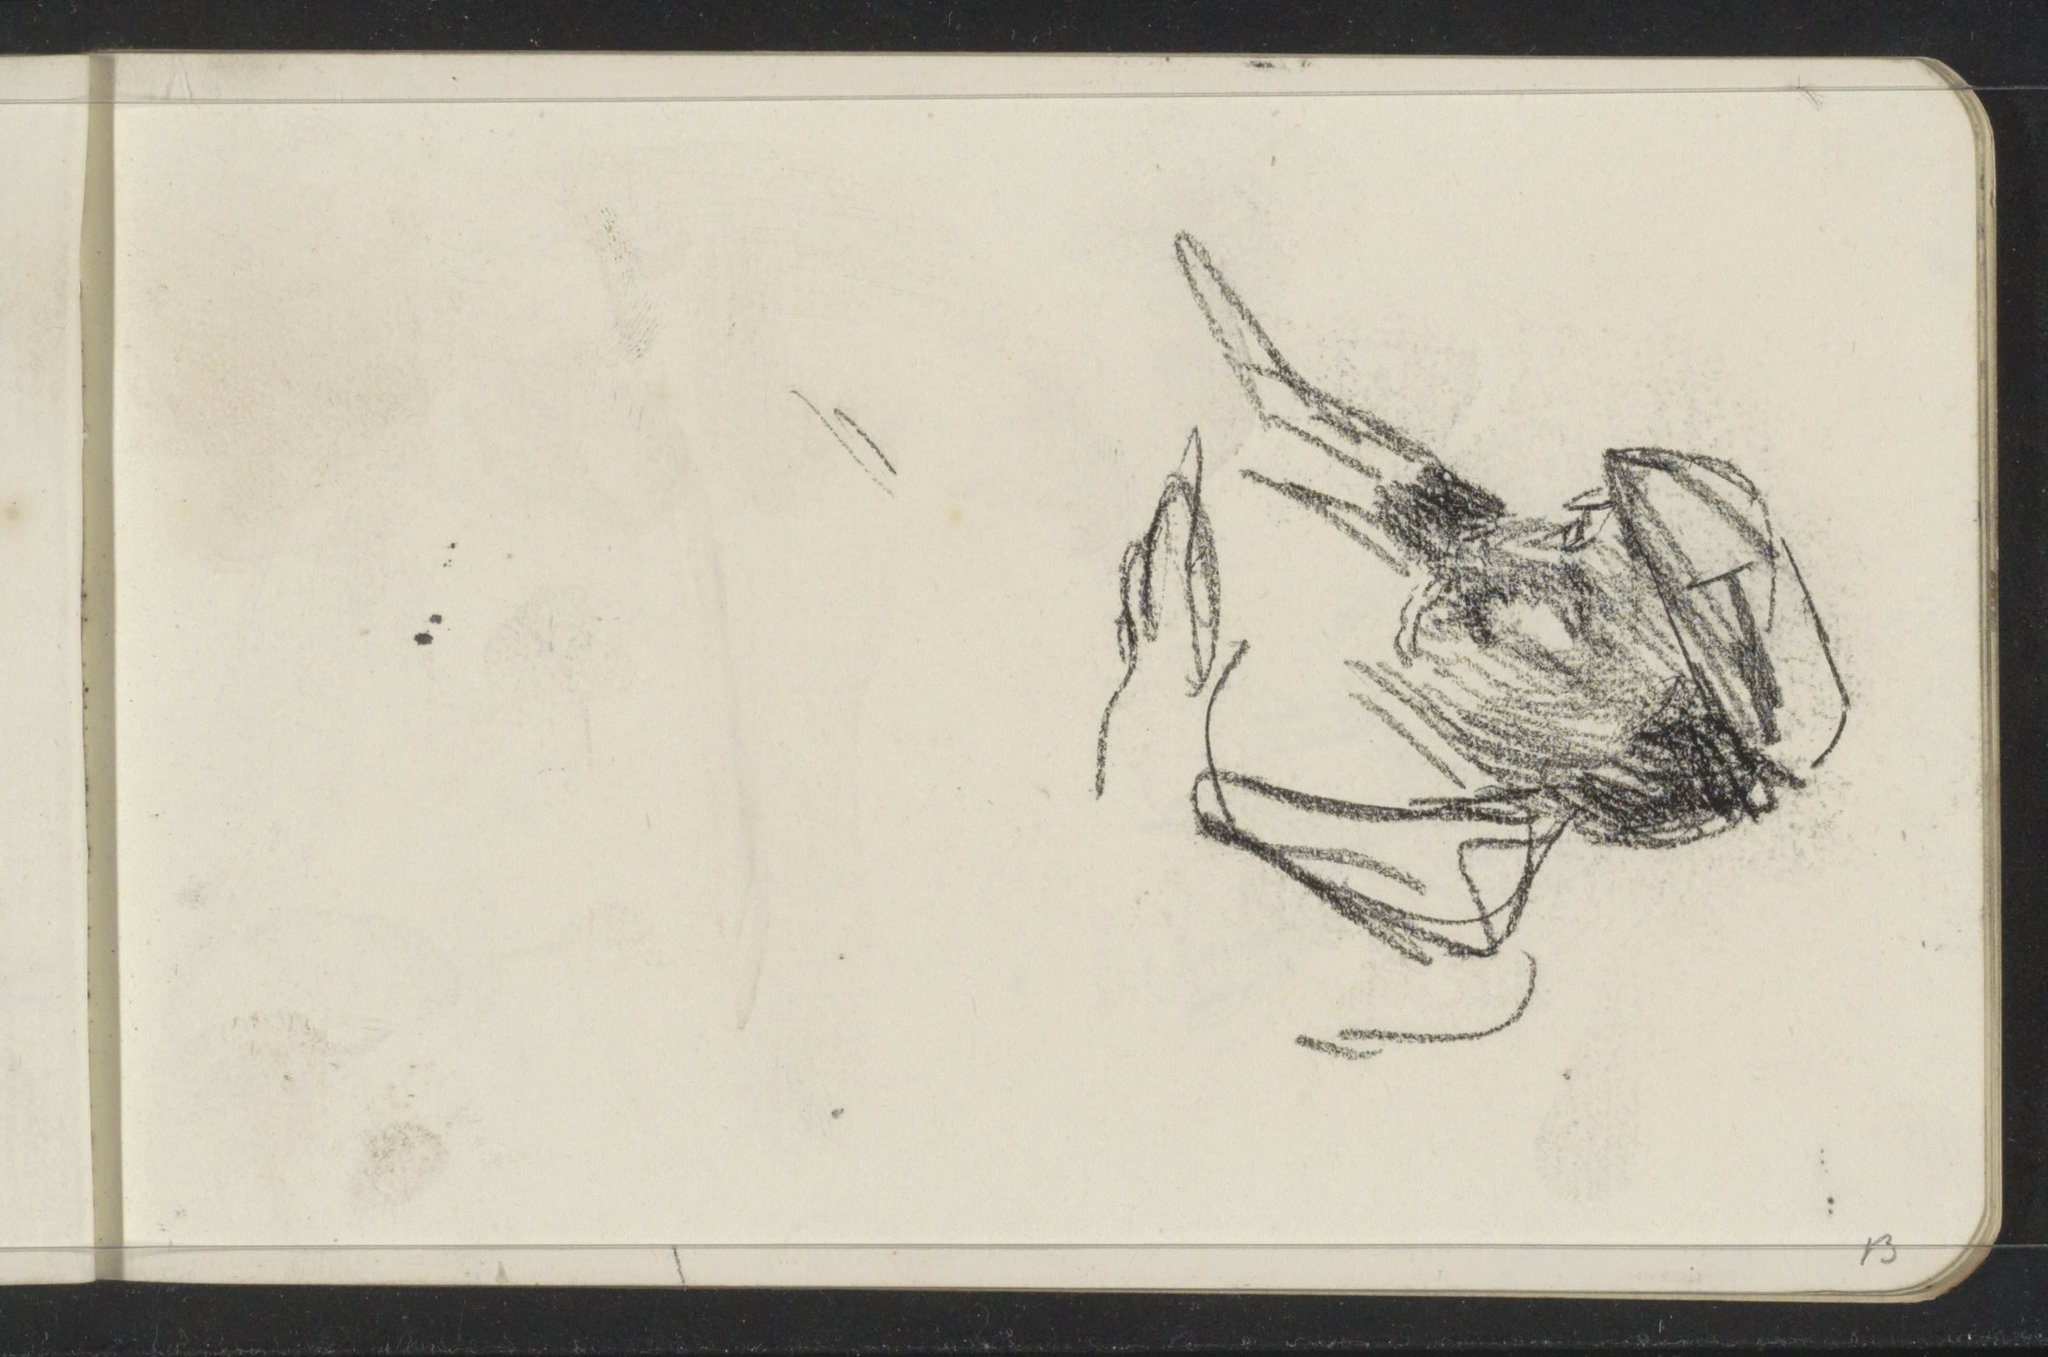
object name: sketchbook leaf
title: Figuurstudie, mogelijk een man met pet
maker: isaac israels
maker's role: draughtsman, painter, print maker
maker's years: 1865-1934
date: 1875-1934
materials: chalk, paper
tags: adult man, head-gear: cap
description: Blad 13 recto uit schetsboek LXII met 28 bladen.